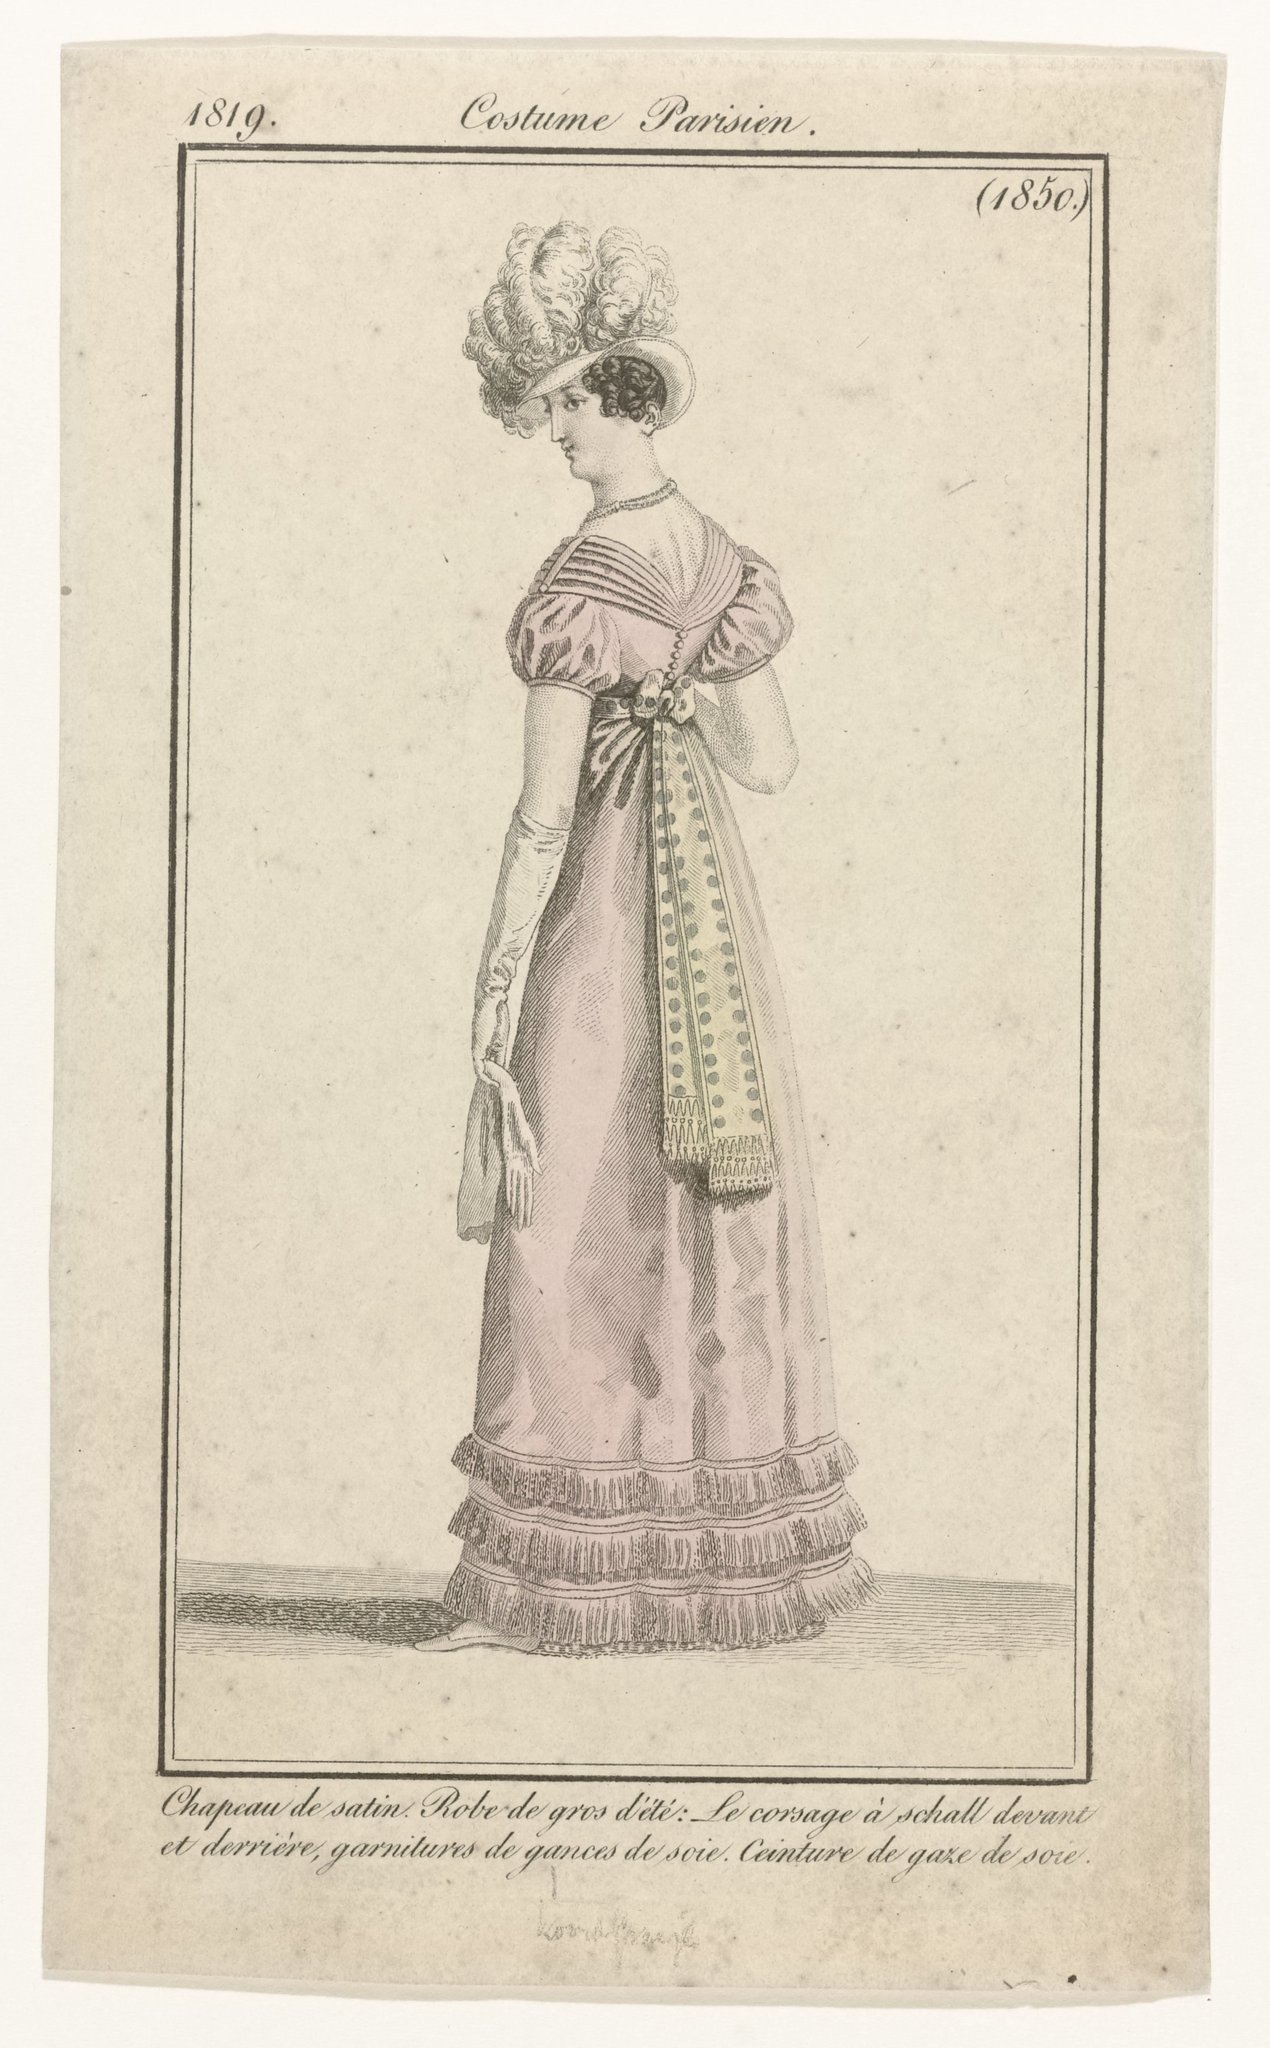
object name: fashion print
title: Journal des Dames et des Modes, Costumes Parisiens, 15 octobre 1819, (1850): Chapeau de satin (...)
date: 1819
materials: paper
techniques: engraving, hand coloring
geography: paris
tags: gloves, mittens (long gloves) (+ women's clothes), fashion plates, head-gear: hat (+ women's clothes), dress, gown (+ women's clothes), belt, girdle, waistband (+ women's clothes)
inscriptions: title: ‘Costume Parisien.’, caption: ‘Chapeau de satin. Robe de gros d'été: Le corsage à shall devant et derrière, garnitures de gances de soie. Ceinture de gaze de soie.’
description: Vrouw, op de rug gezien, gekleed in een japon van 'gros d'été' met garneringen van zijden 'gances'. Op het hoofd een hoed van satijn. Ceintuur van 'gaze de soie'. Lange handschoenen, waarvan één los in de hand. De prent maakt deel uit van het modetijdschrift Journal des Dames et des Modes, uitgegeven door Pierre de la Mésangère, Parijs, 1797-1839.